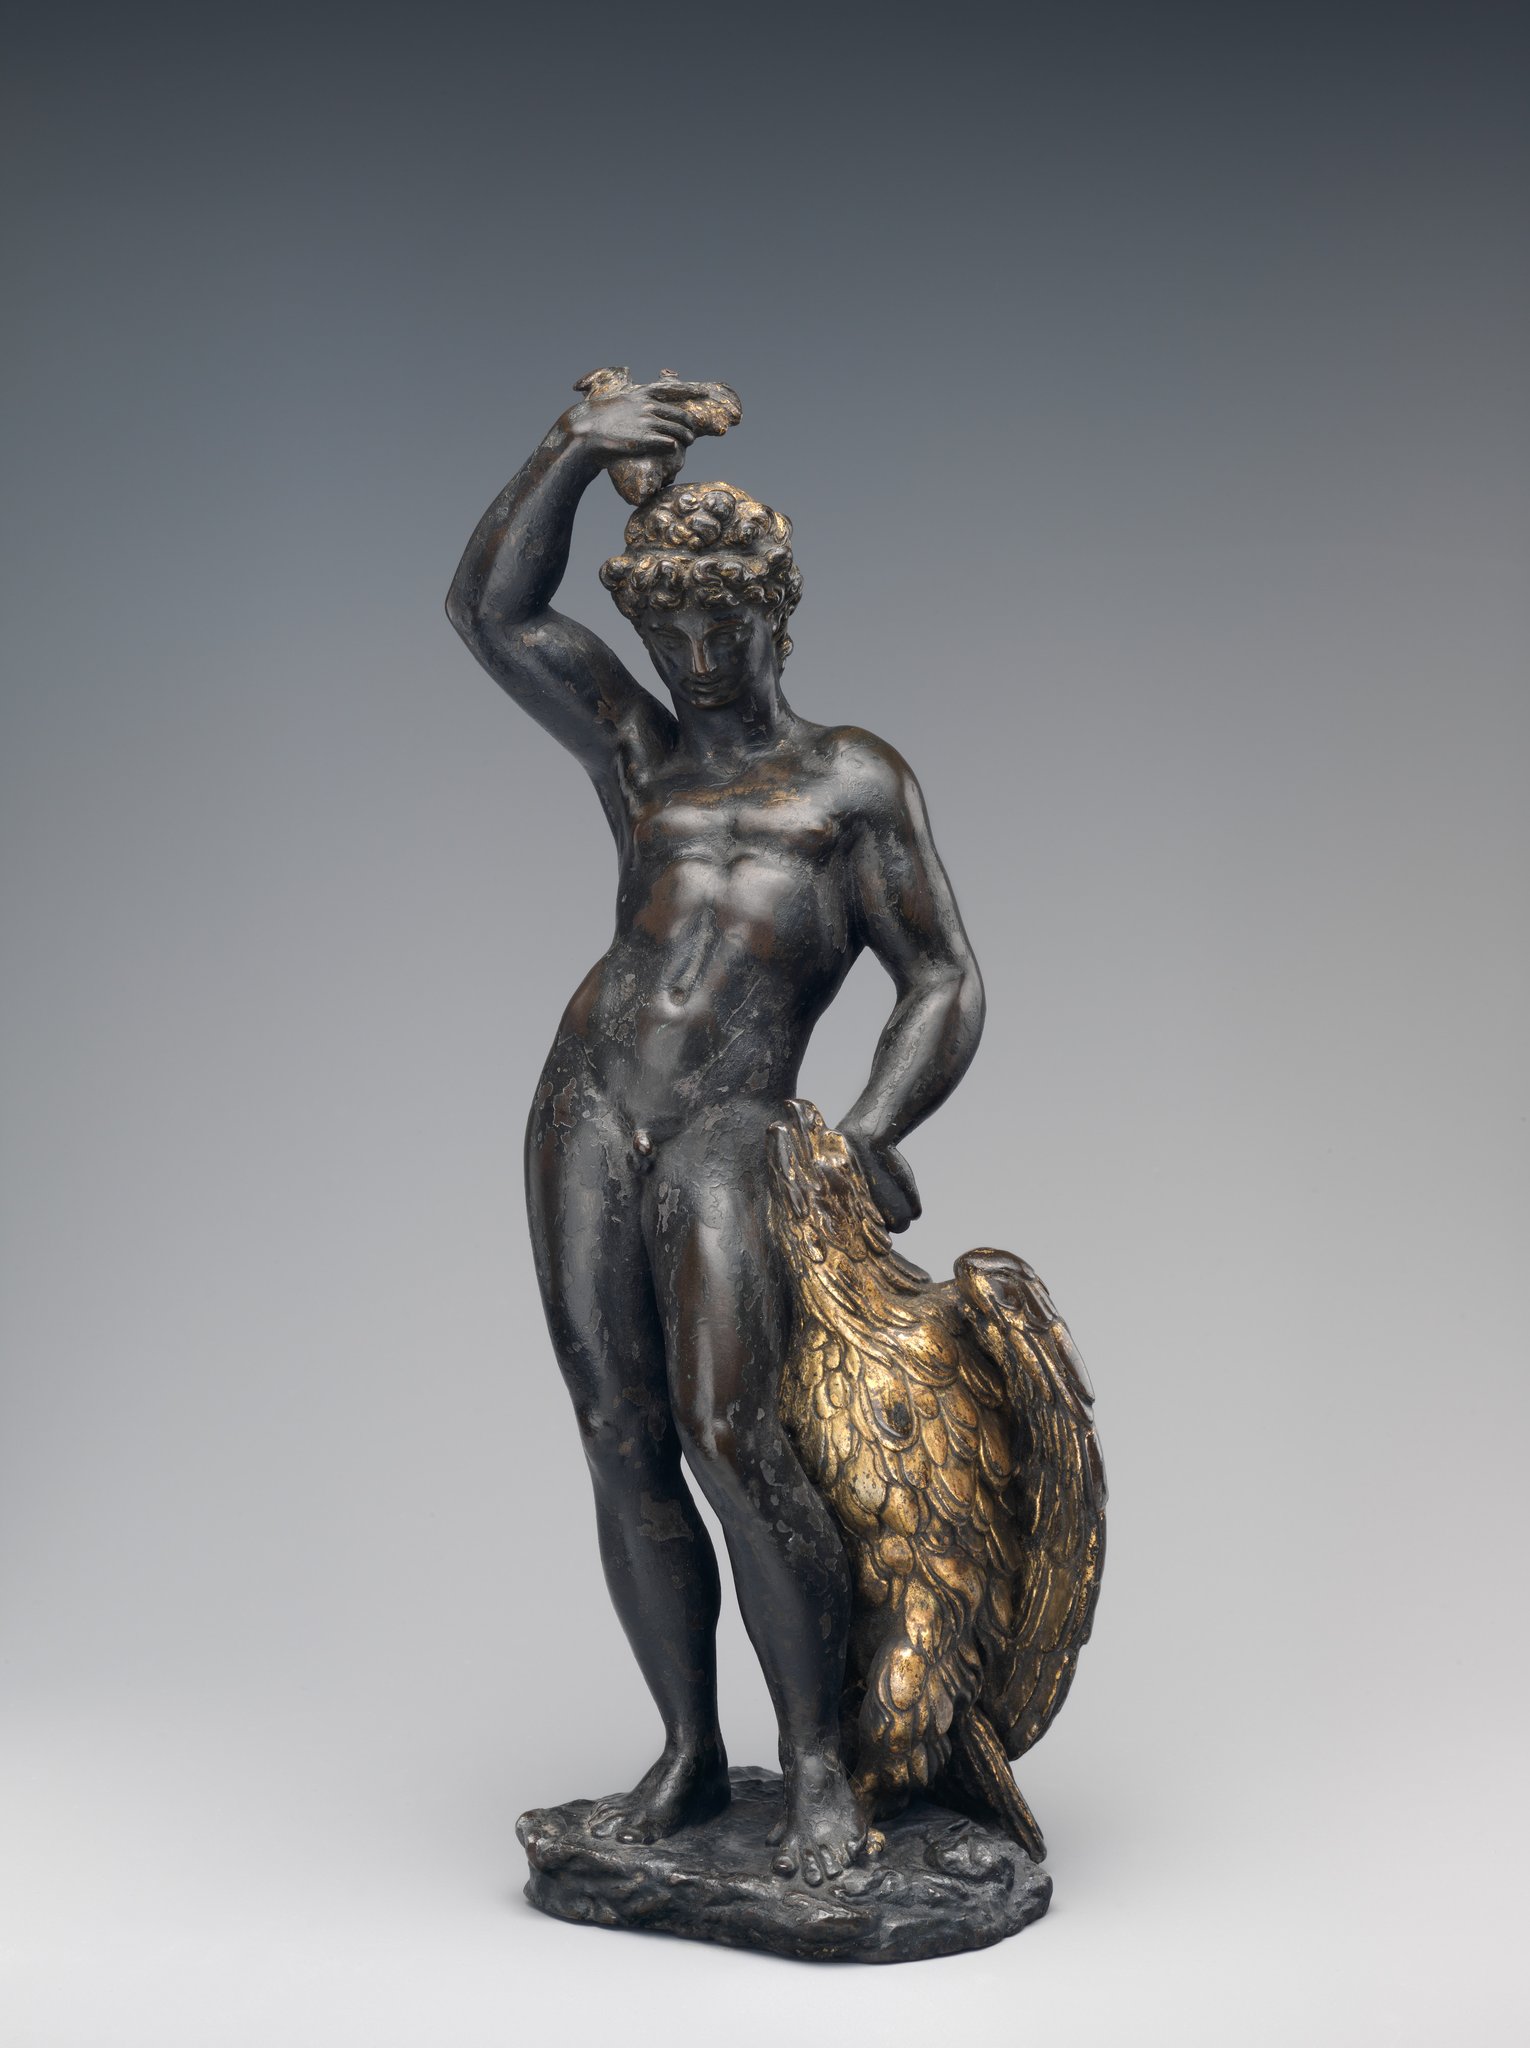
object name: statuette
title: Ganymede with eagle and eaglet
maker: benvenuto cellini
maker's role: artist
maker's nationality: italian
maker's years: 1500-1571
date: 1701-1800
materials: bronze, gilt, oil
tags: eagles,male nudes